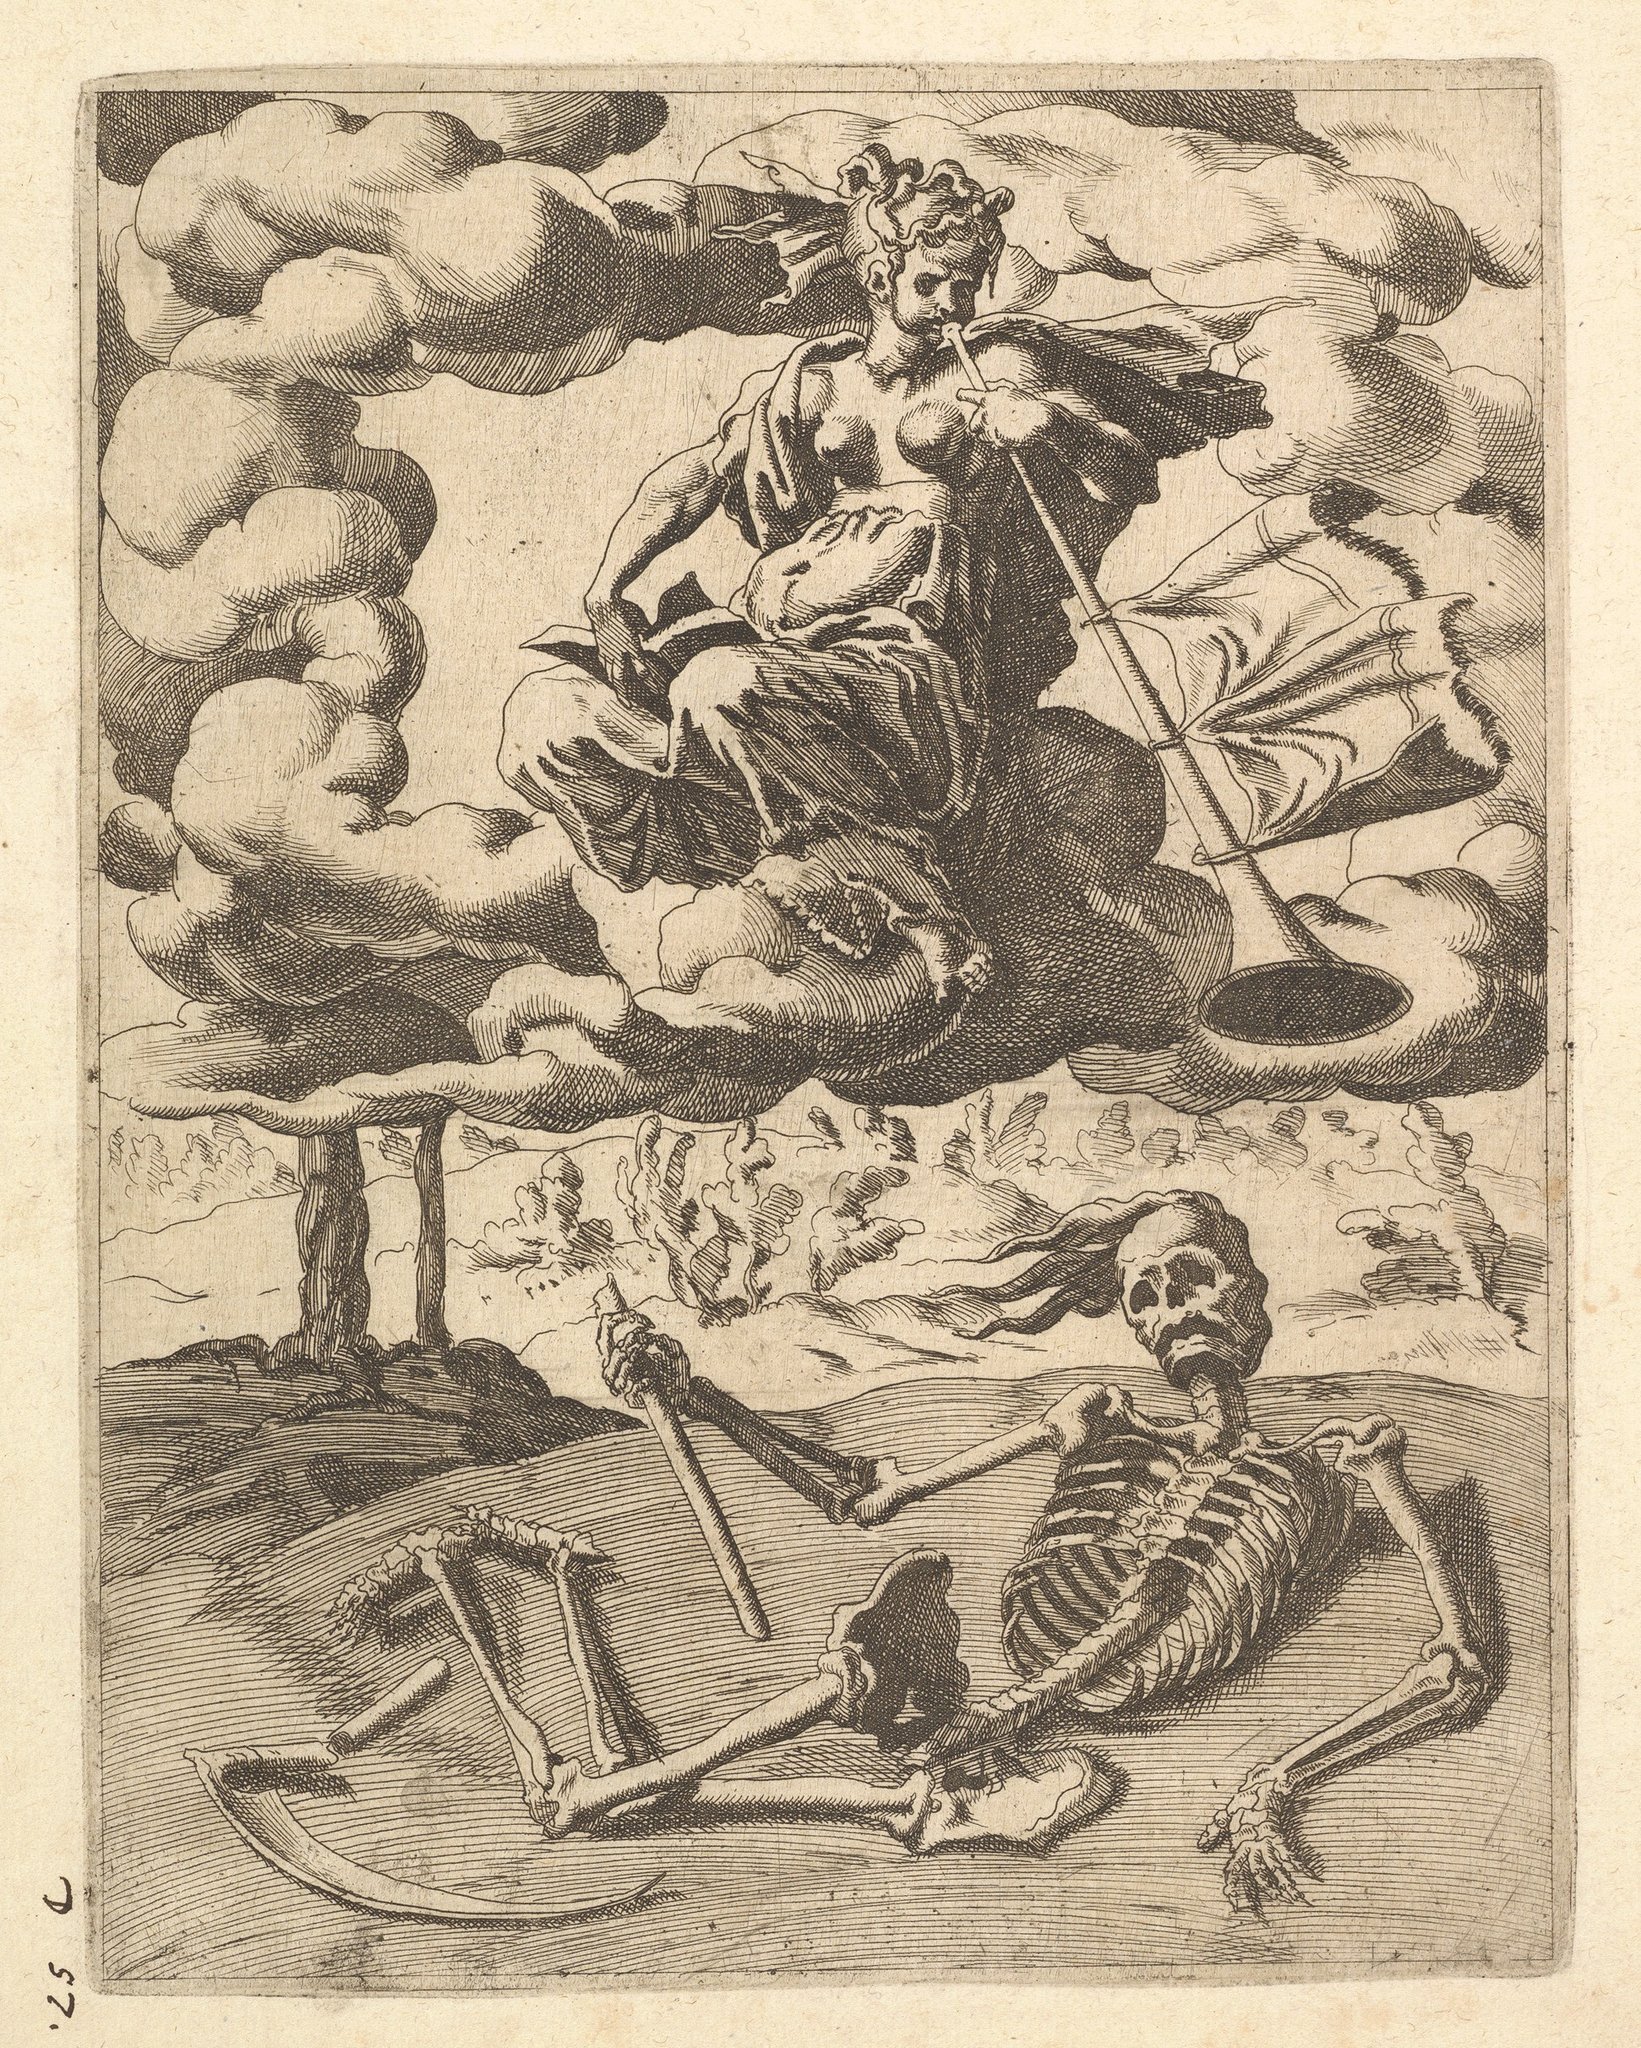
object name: print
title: The Triumph of Fame from The Triumphs of Petrarch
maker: dirck volckertsz coornhert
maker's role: artist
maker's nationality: netherlandish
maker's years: 1519-1590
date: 1548-1549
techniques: etching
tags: musical instruments,skeletons